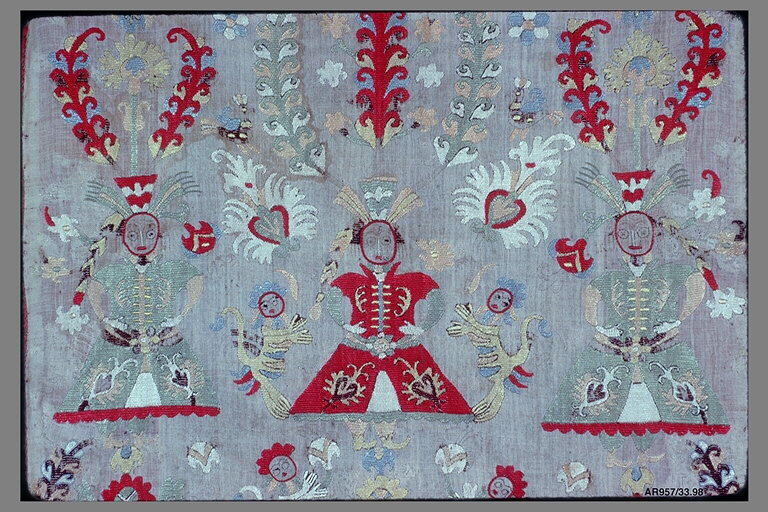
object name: band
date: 1701-1800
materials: cotton, silk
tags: birds,women,mythical creatures